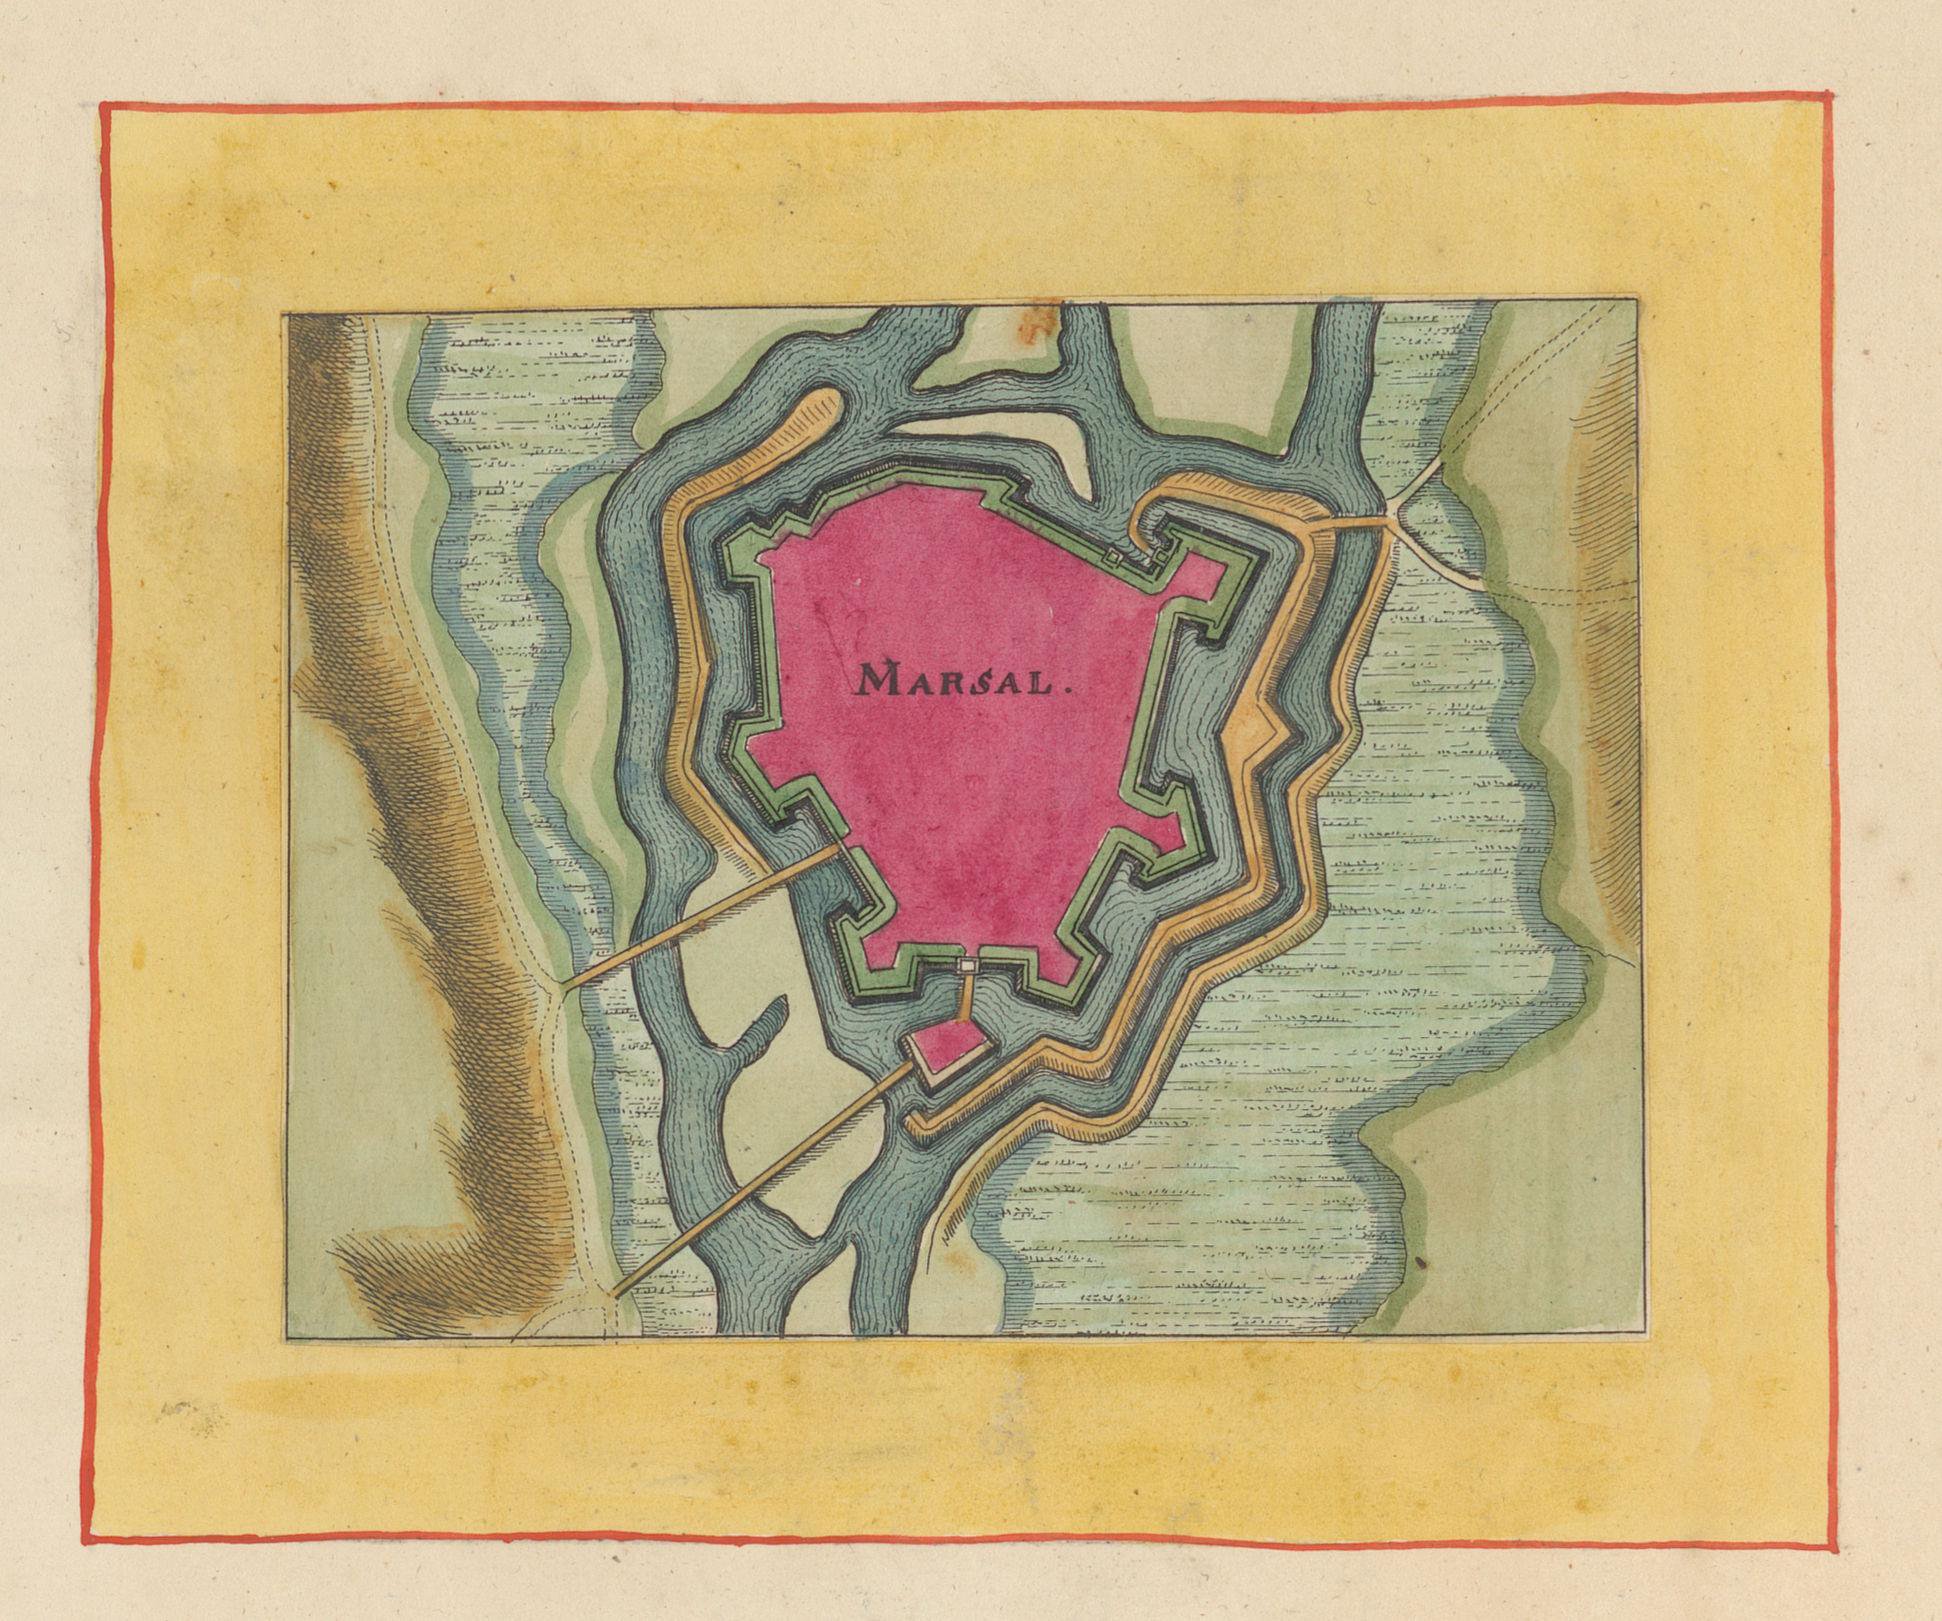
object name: area plan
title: Vestingplattegrond van Marsal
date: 1656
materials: paper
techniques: engraving, etching, hand coloring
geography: frankfurt am main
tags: maps of cities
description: Prent uit: Zeiller, Martin. Topographia Galliae. 13 dln. Frankfurt: Caspar Merian, 1656, dl. 3, na p. 16. Origineel op één blad gedrukt met de plattegrond van Jametz (RP-P-1957-607-155-1).